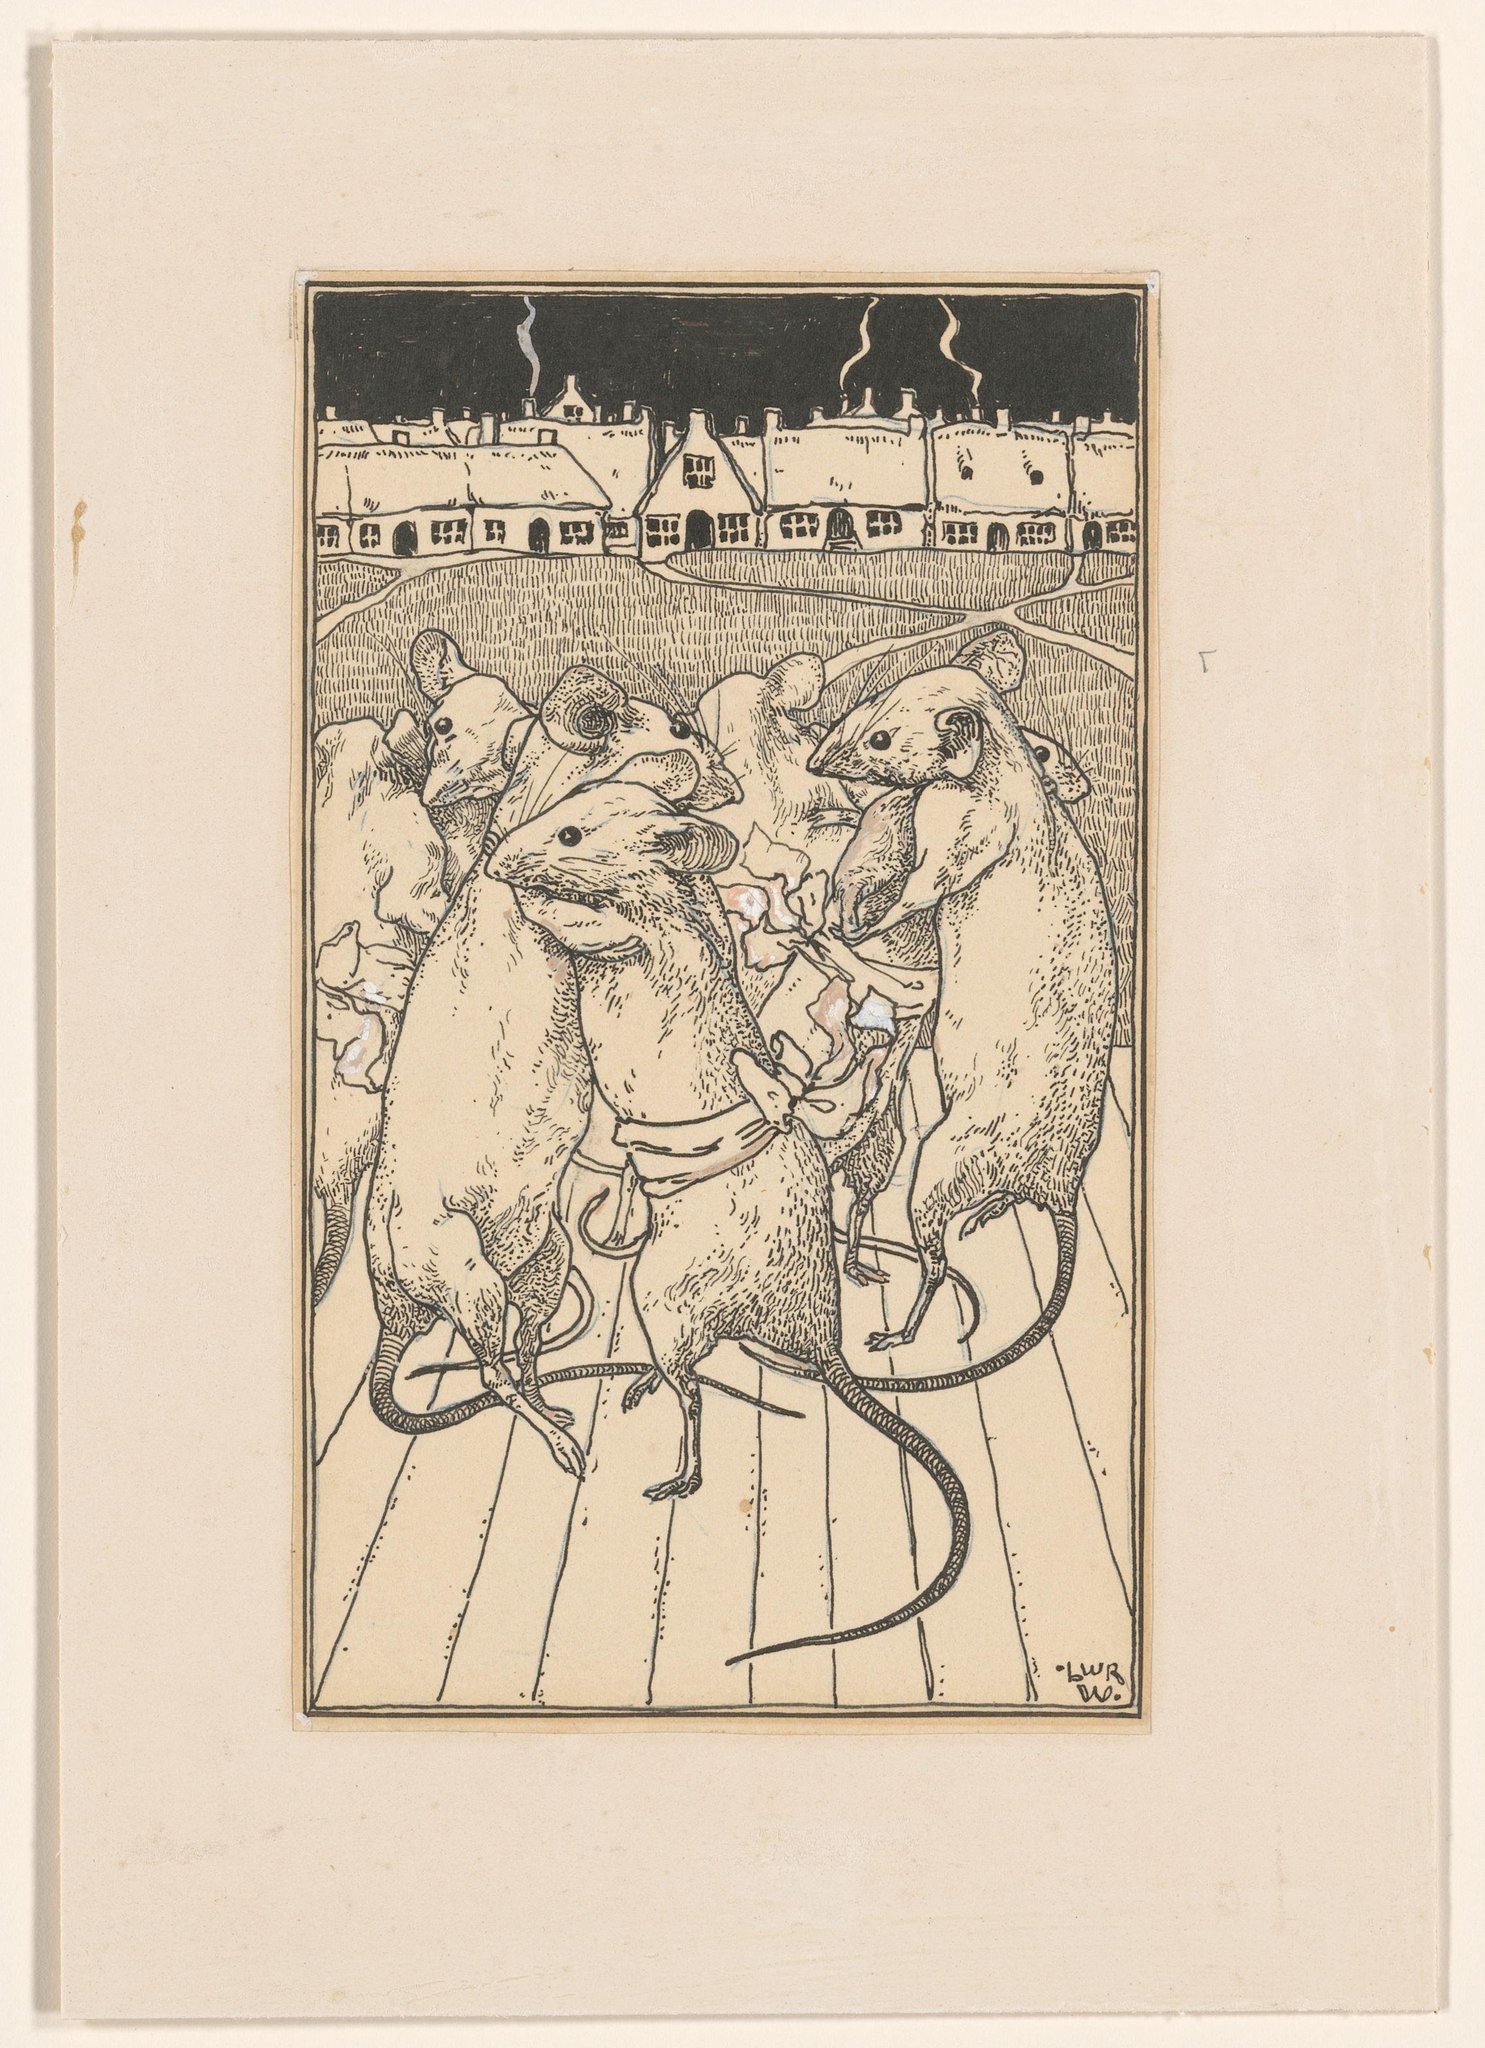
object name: boekillustratie ontwerp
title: Dansende muizen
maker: willem wenckebach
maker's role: designer, draughtsman, painter, print maker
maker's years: 1860-1937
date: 1894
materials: cardboard, paint, ink, paper, pencil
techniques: brush, pen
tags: rodents: mouse, one pair dancing; man and woman dancing as a couple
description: De muizen dansen in paren op een plankenvloer. De vrouwen dragen een sjerp. In de achtergrond zijn de huizen van de muizen te zien. Ontwerp voor 'De volksspelen', het derde hoofdstuk van de publicatie.